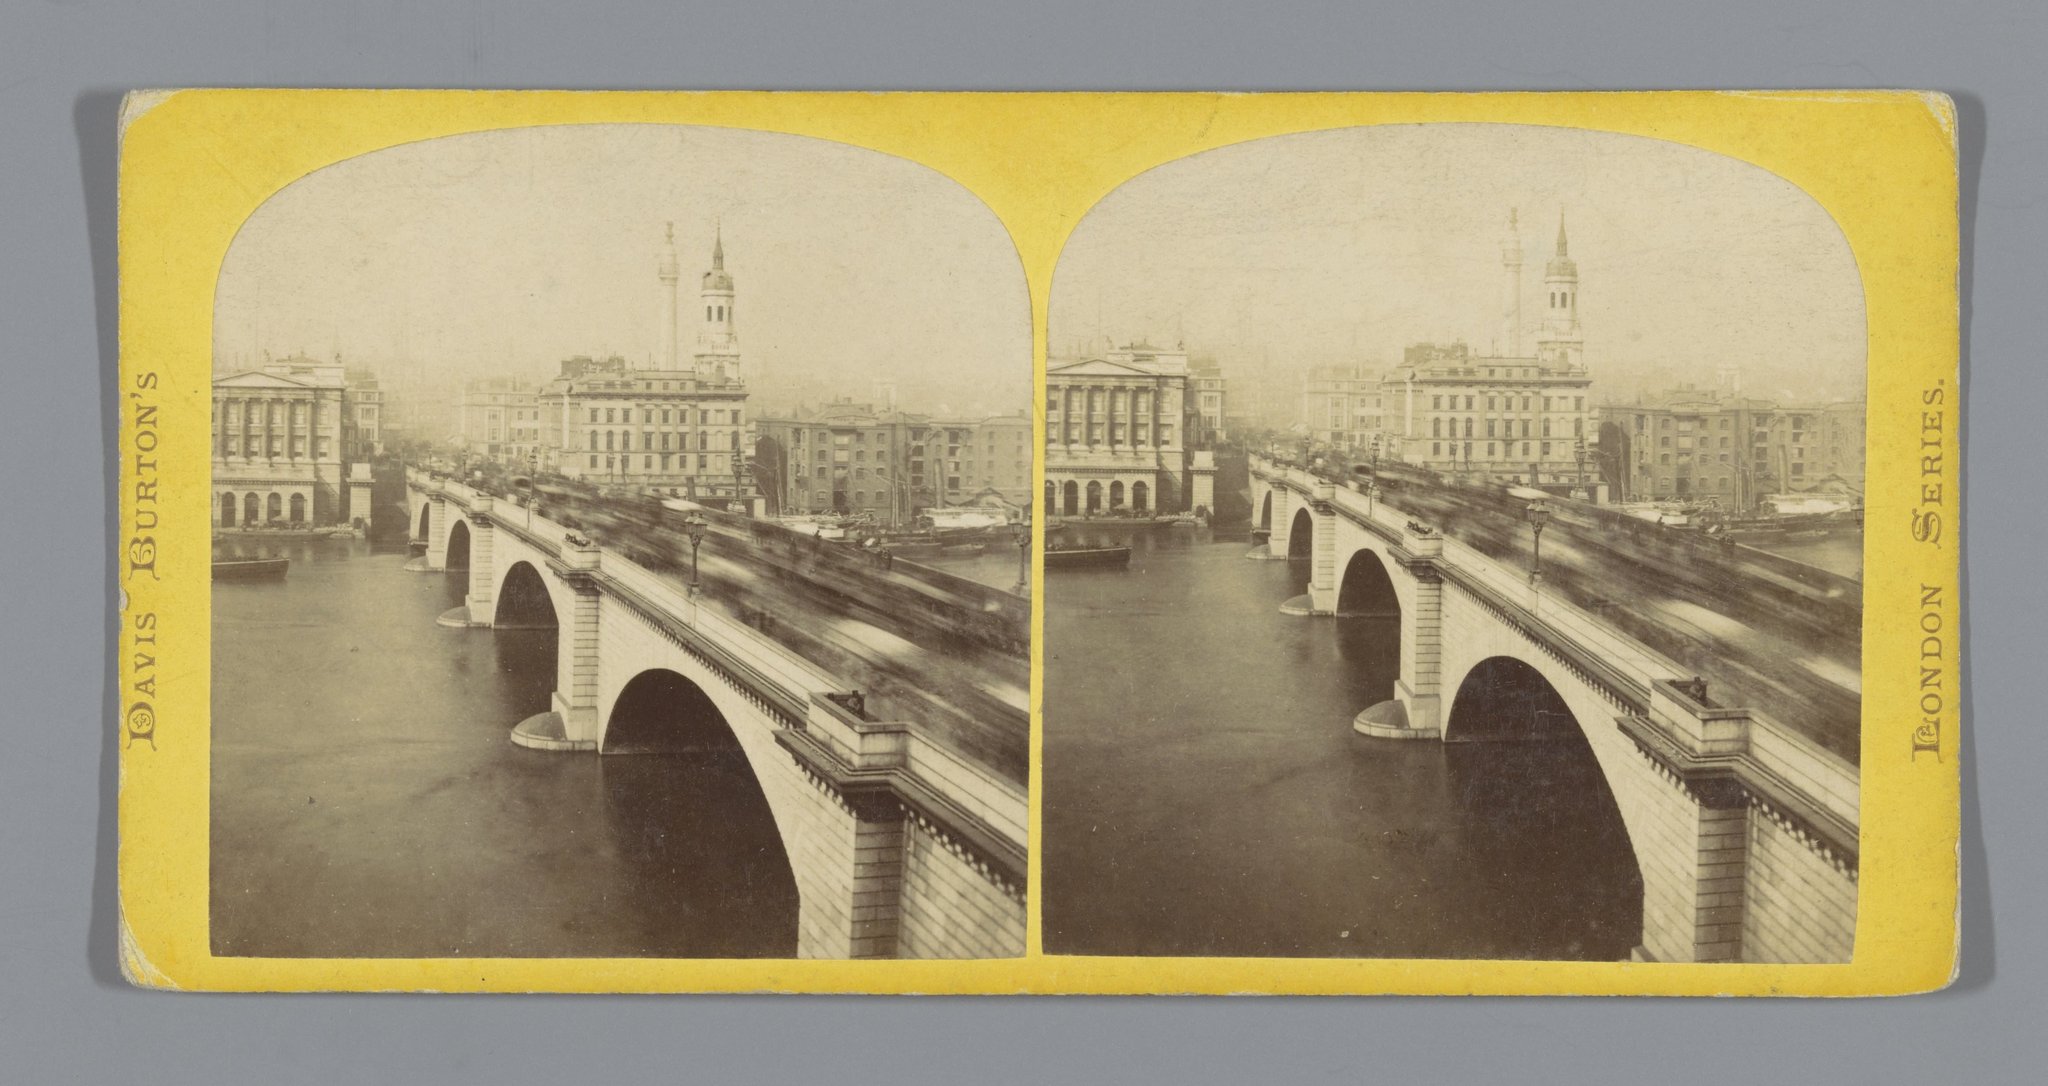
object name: stereograph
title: Gezicht op de London Bridge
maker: james davis burton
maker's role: fotograaf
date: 1860-1880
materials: cardboard, photographic support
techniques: albumen print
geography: london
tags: bridge in city across river, canal, etc.